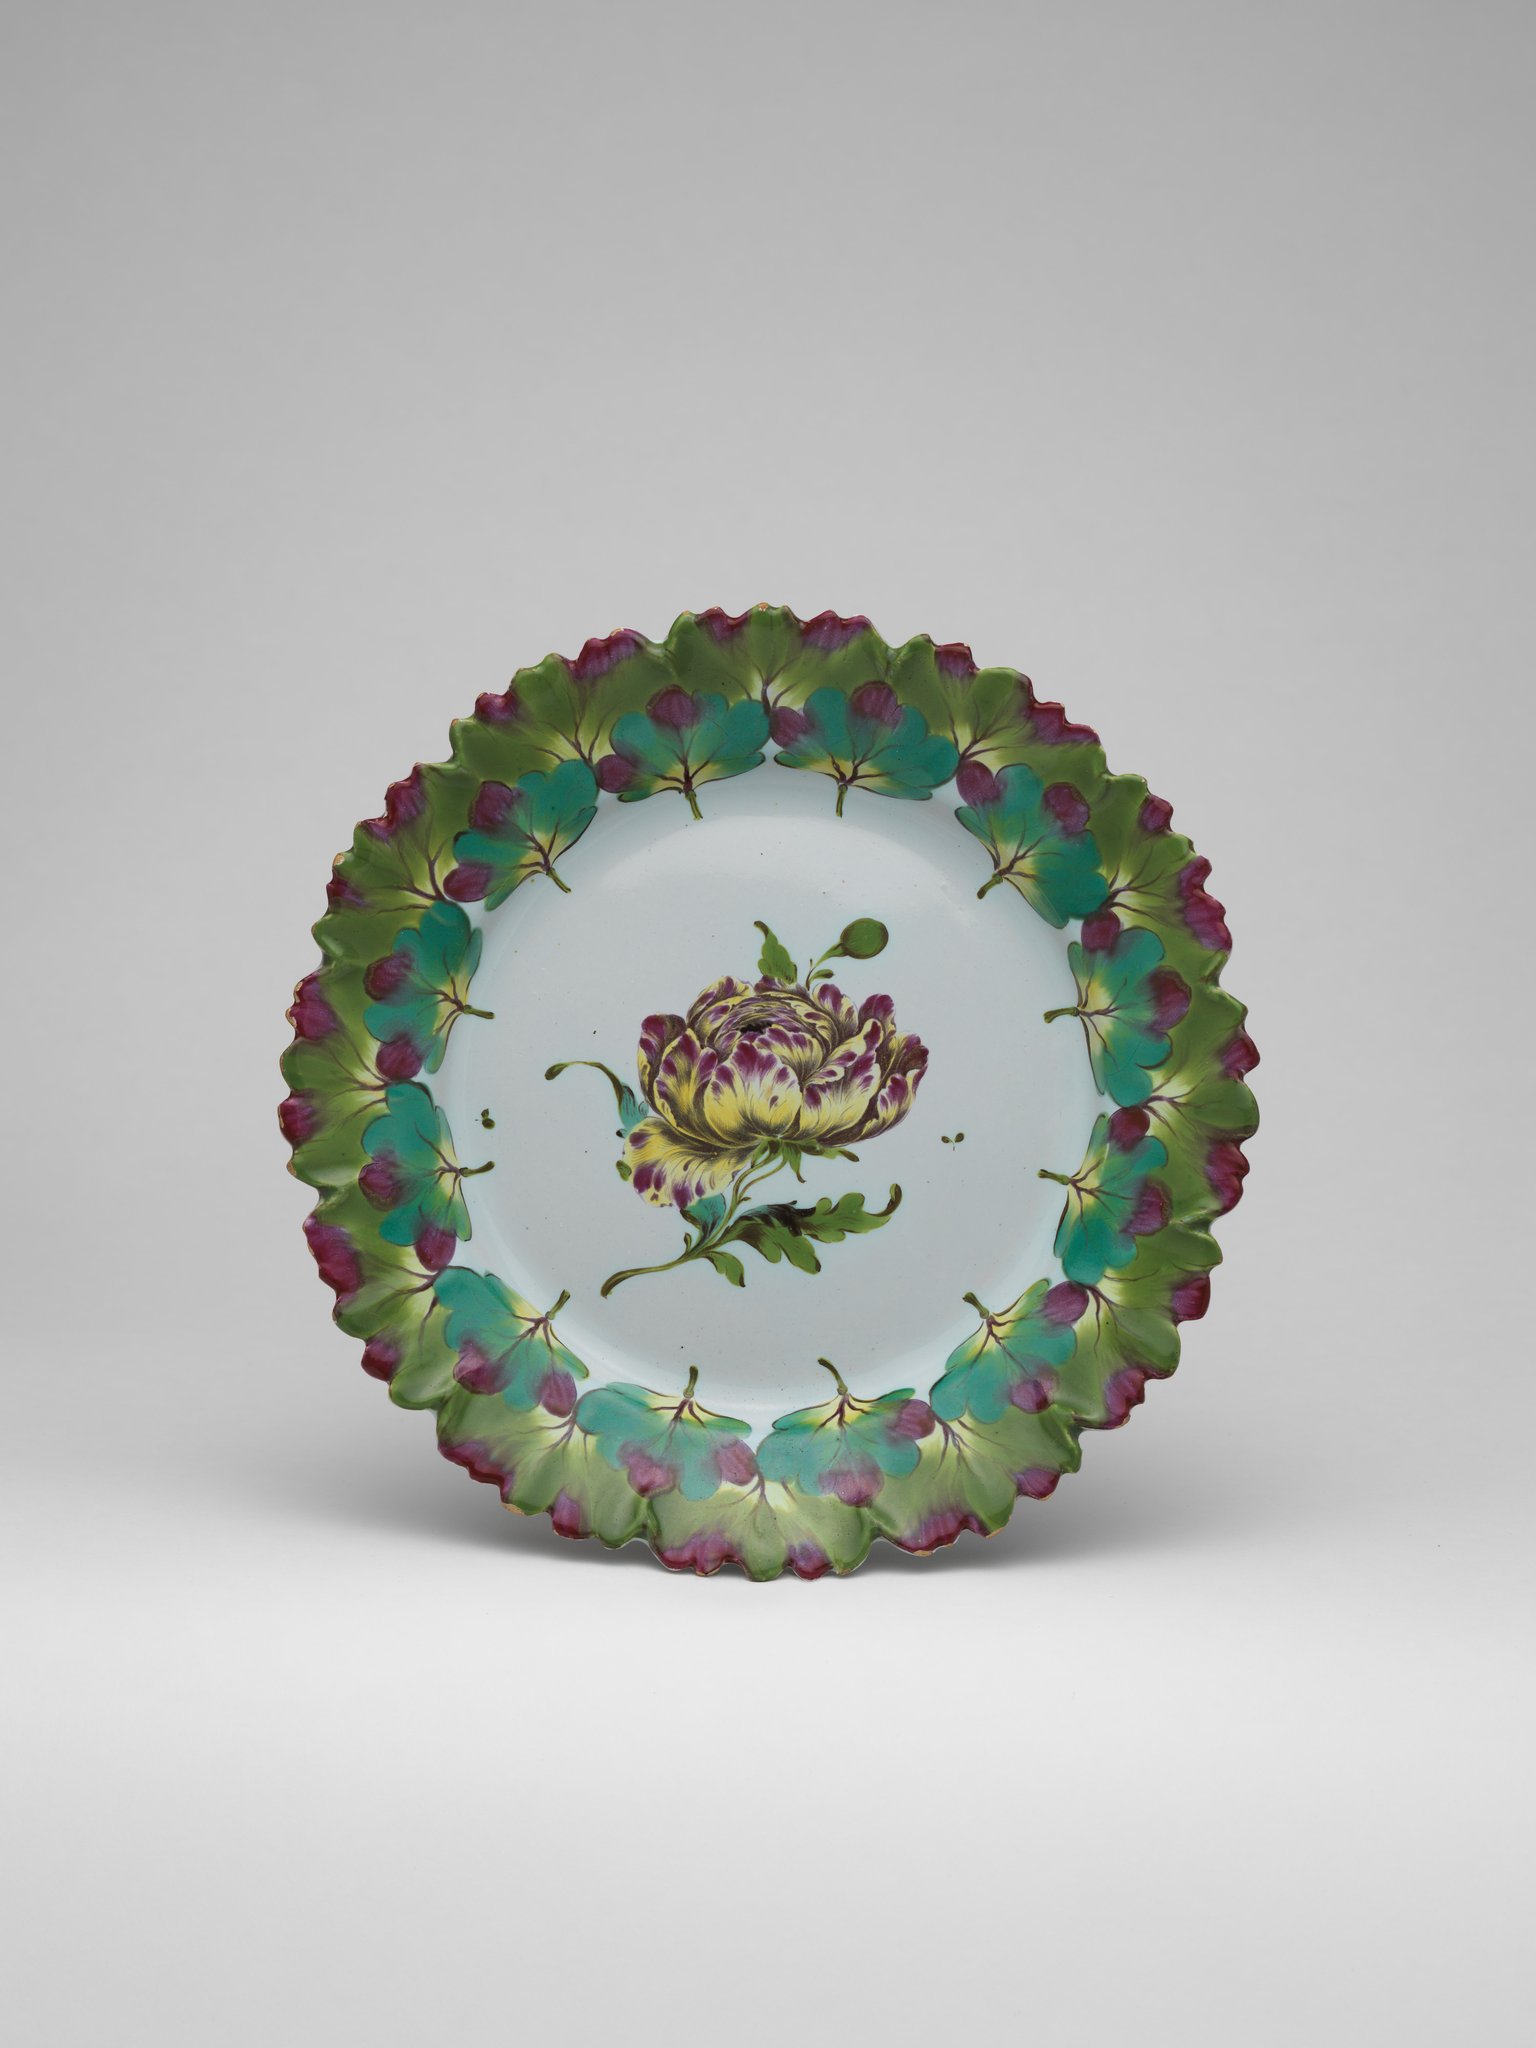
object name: plate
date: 1765-1770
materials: faience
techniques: glazing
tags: flowers